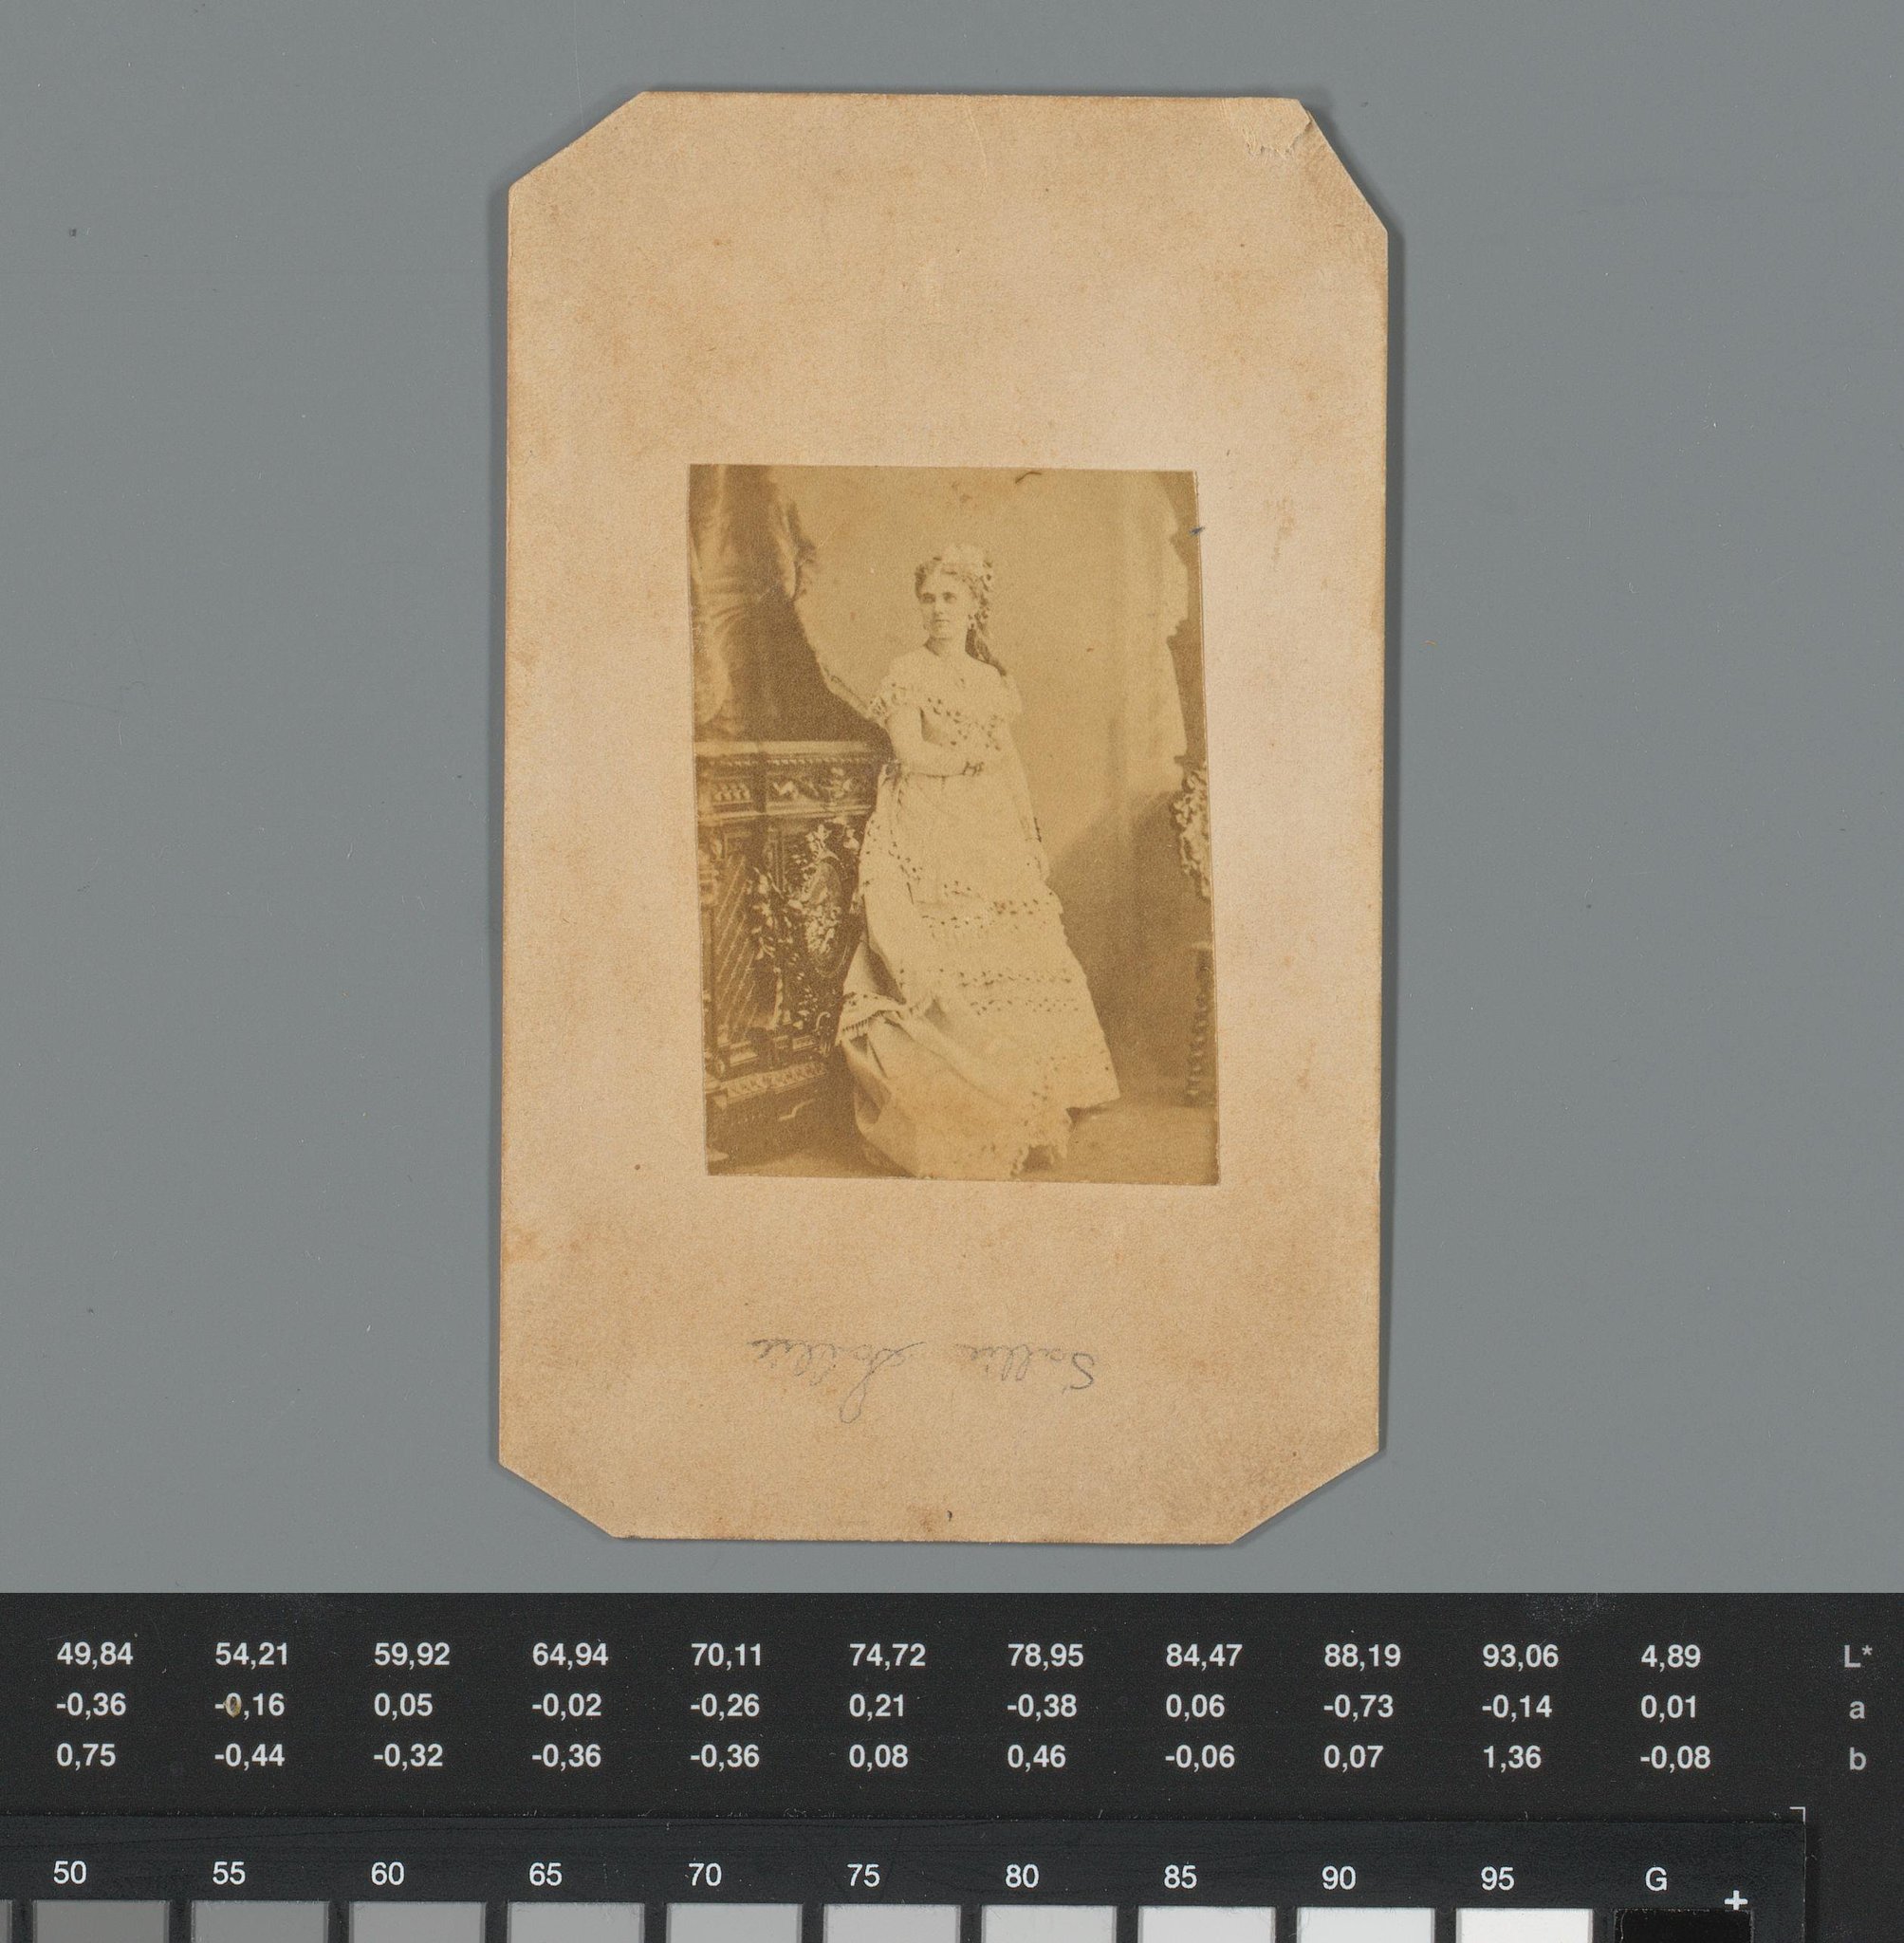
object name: photograph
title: Portret van een onbekende vrouw met reclame voor E. B. Howe in Spencer, Indiana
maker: Anonymous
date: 1850-1915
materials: cardboard, photographic support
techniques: albumen print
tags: advertising, historical persons not known by name - bb - woman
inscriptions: inscription: ‘(...)’